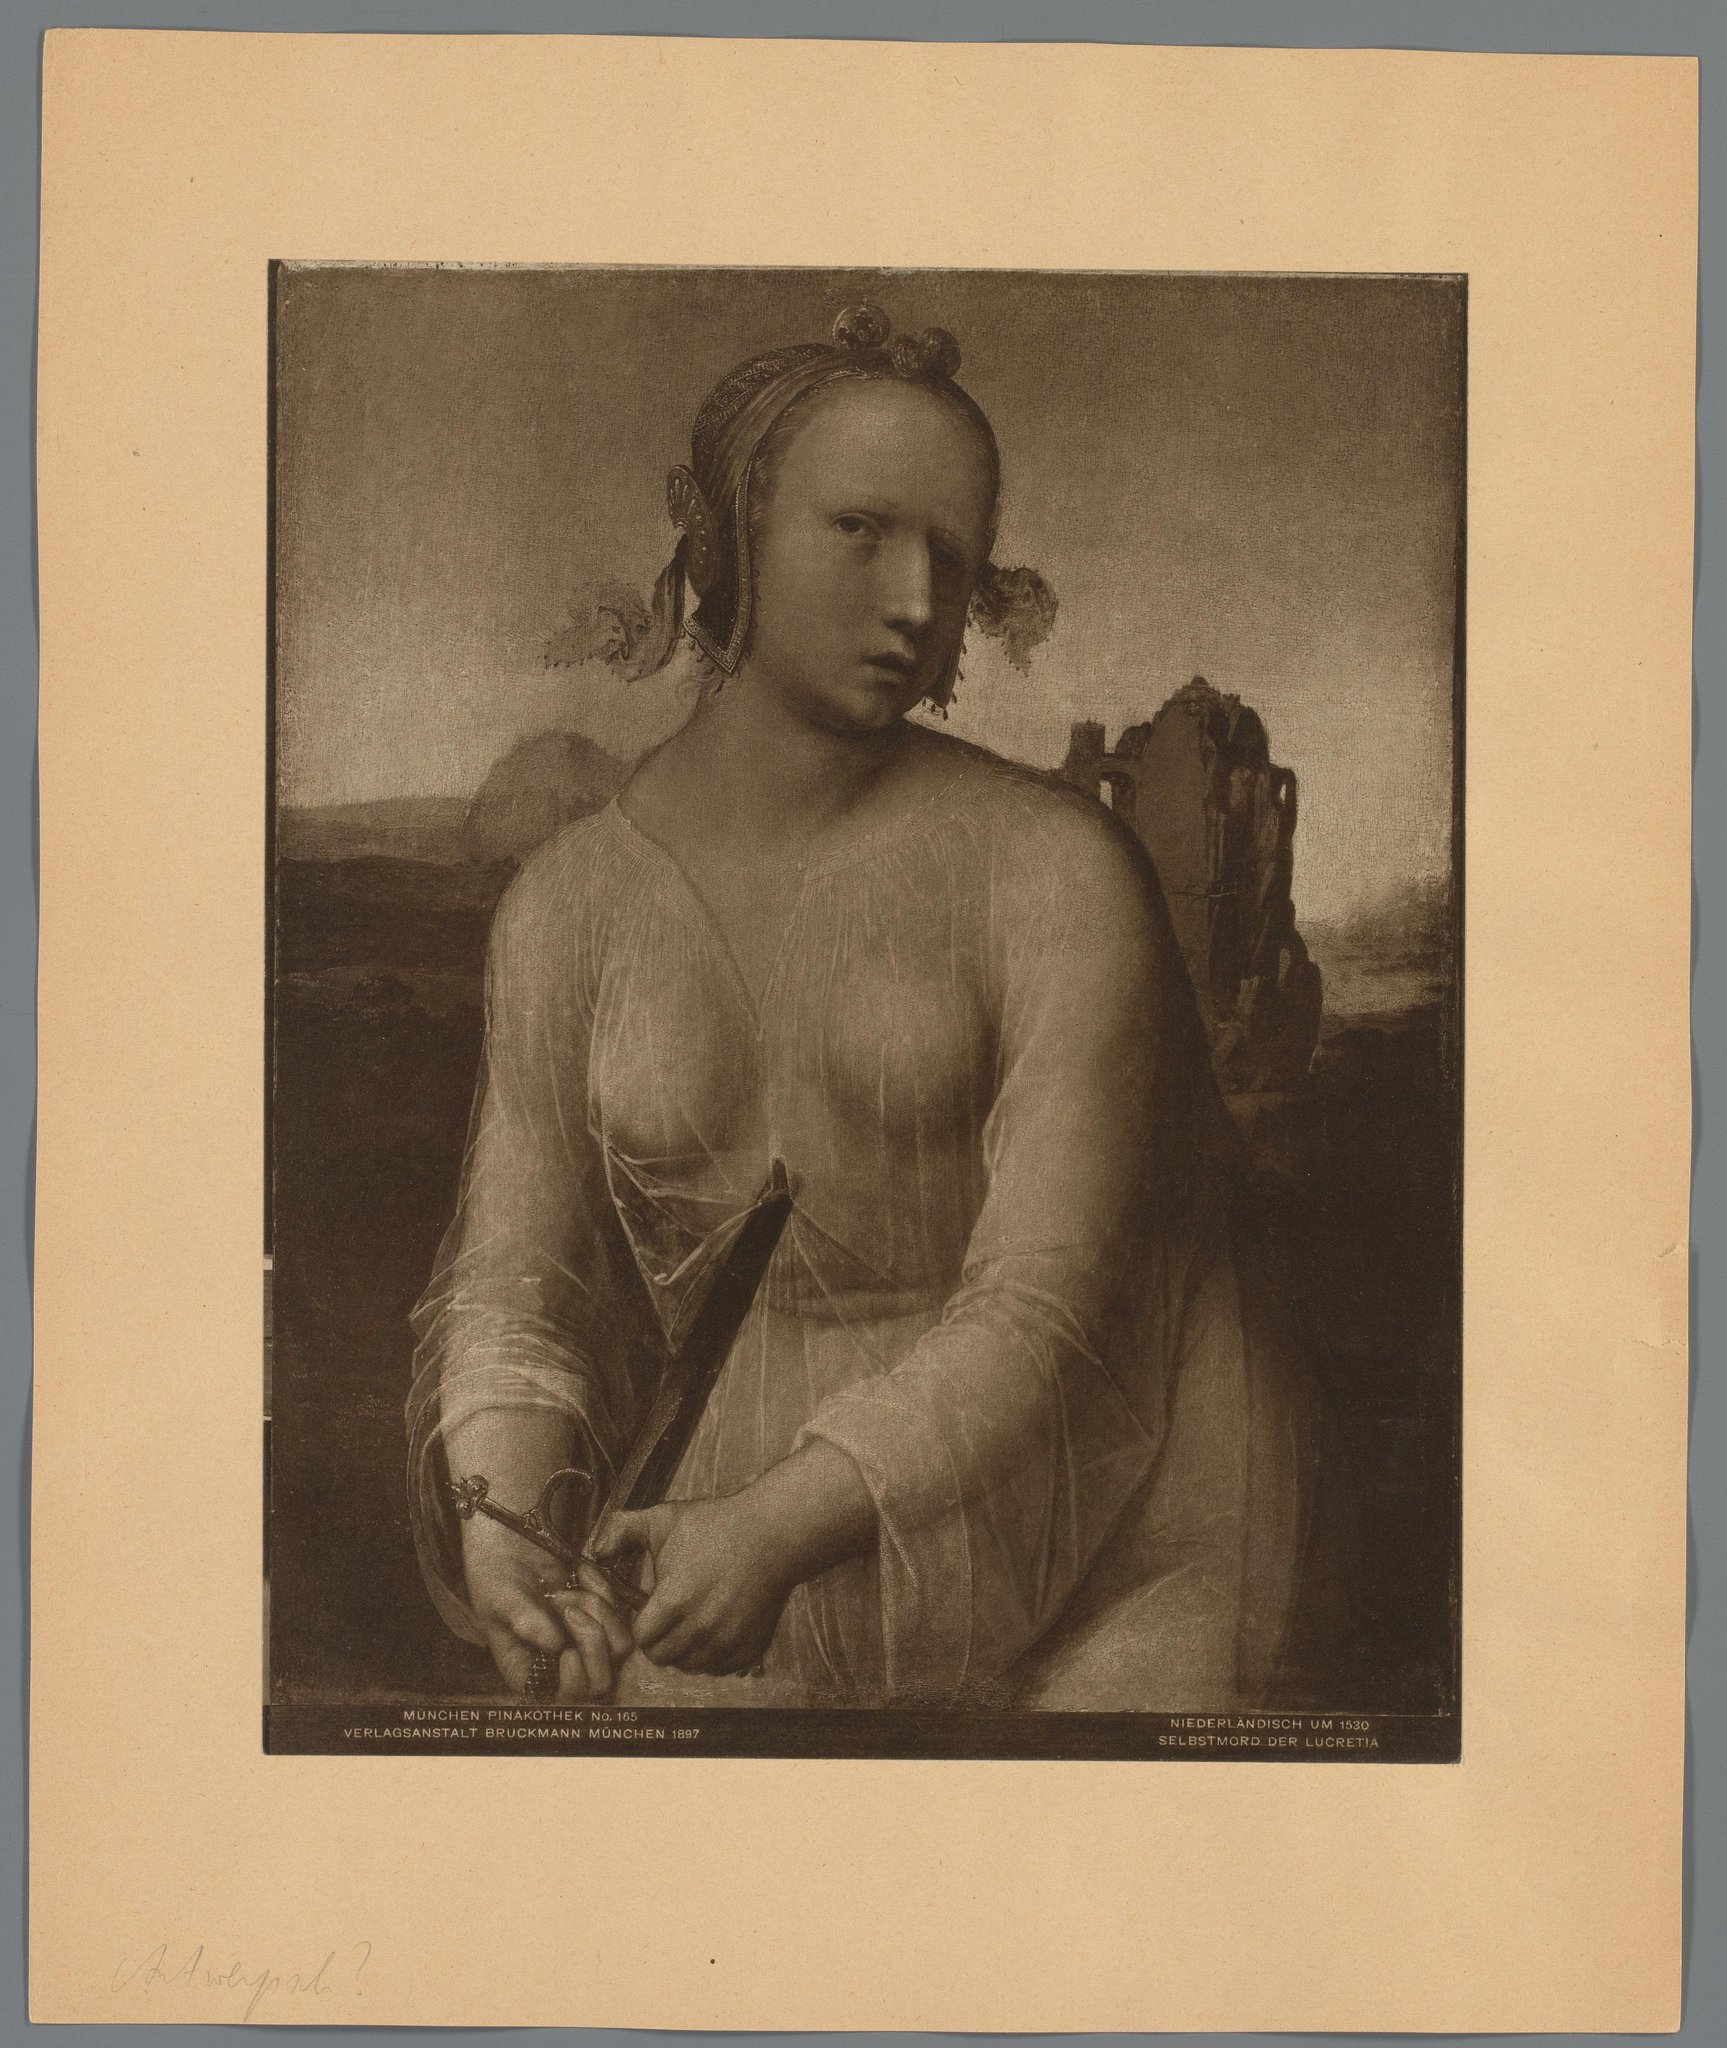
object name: photomechanical print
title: Fotoreproductie van het schilderij Zelfmoord van Lucretia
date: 1897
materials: paper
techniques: photograph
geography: munich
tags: seeking death, suicide, death of lucretia: she commits suicide by stabbing herself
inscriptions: inscription: ‘Antwerpsch?’, inscription: ‘München Pinakothek No. 165/ Niederländisch um 1530’